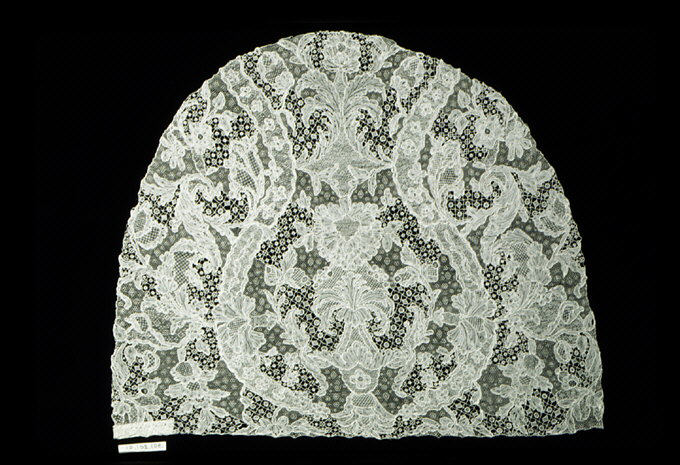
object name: cap crown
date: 1701-1800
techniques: lace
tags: flowers